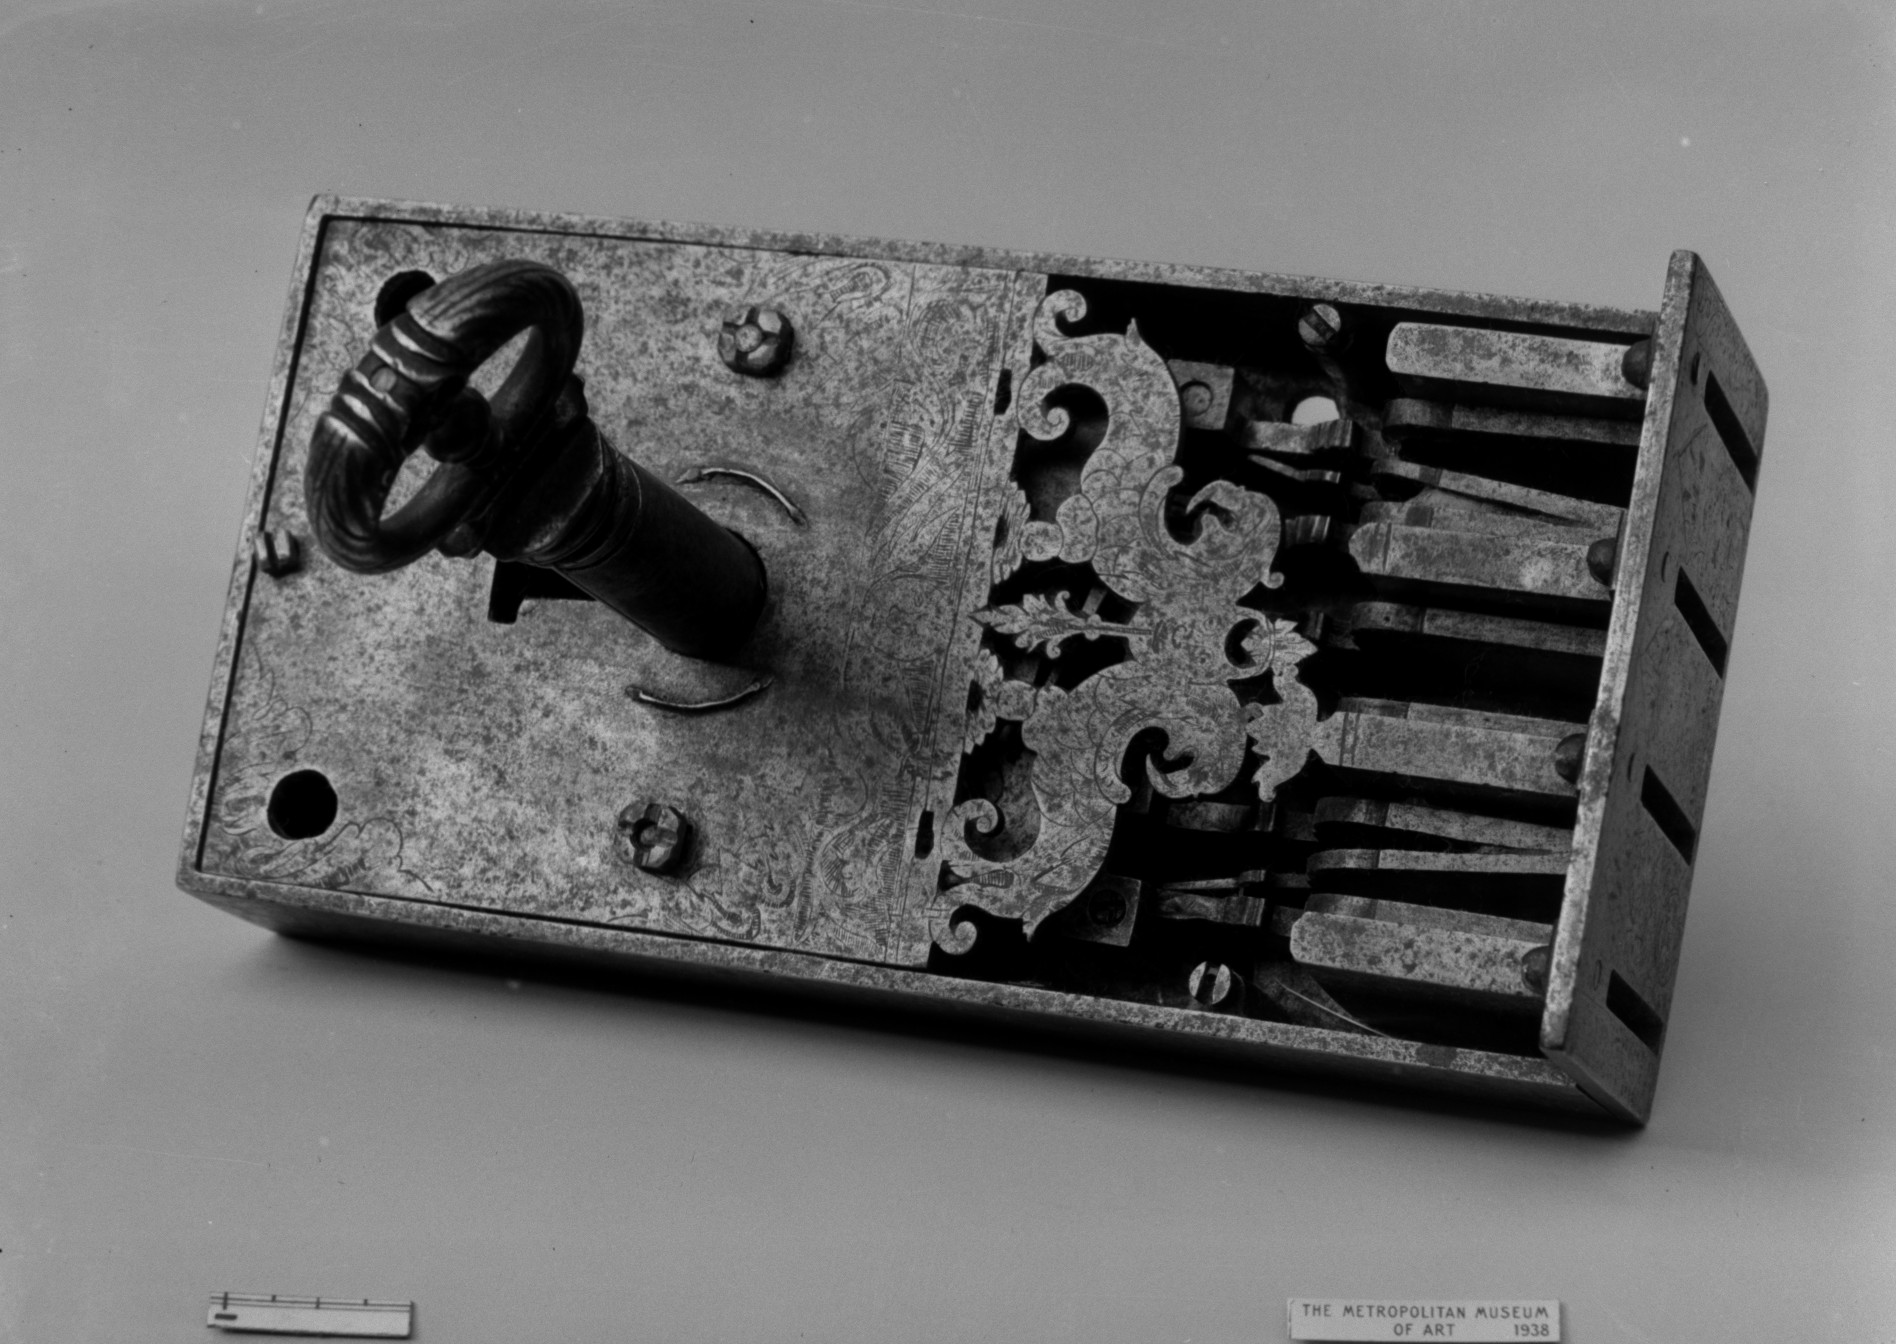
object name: rim lock and key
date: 1501-1600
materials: iron